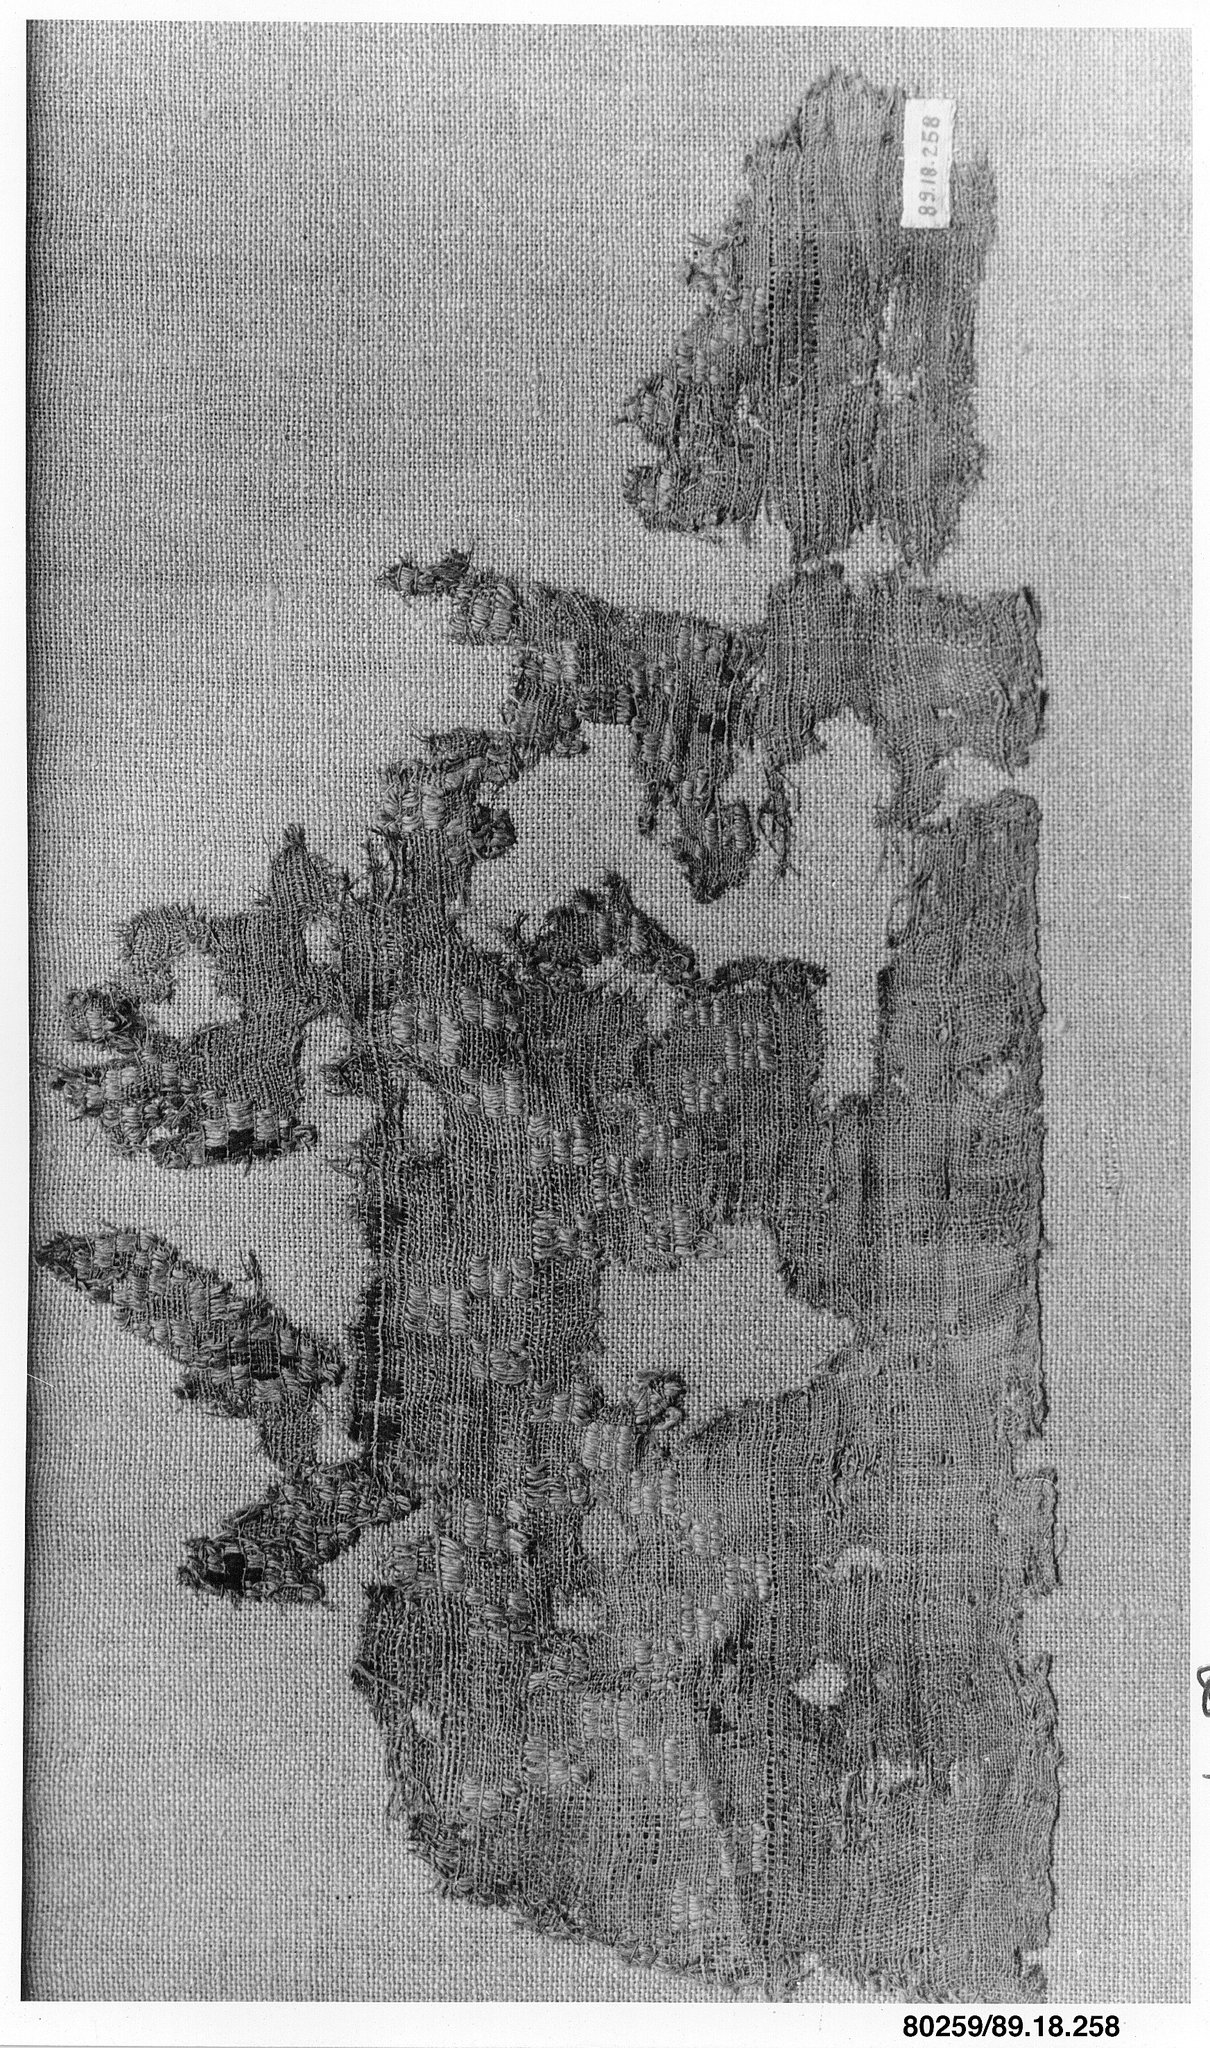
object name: textile fragment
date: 401-600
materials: linen, wool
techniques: weave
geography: egypt